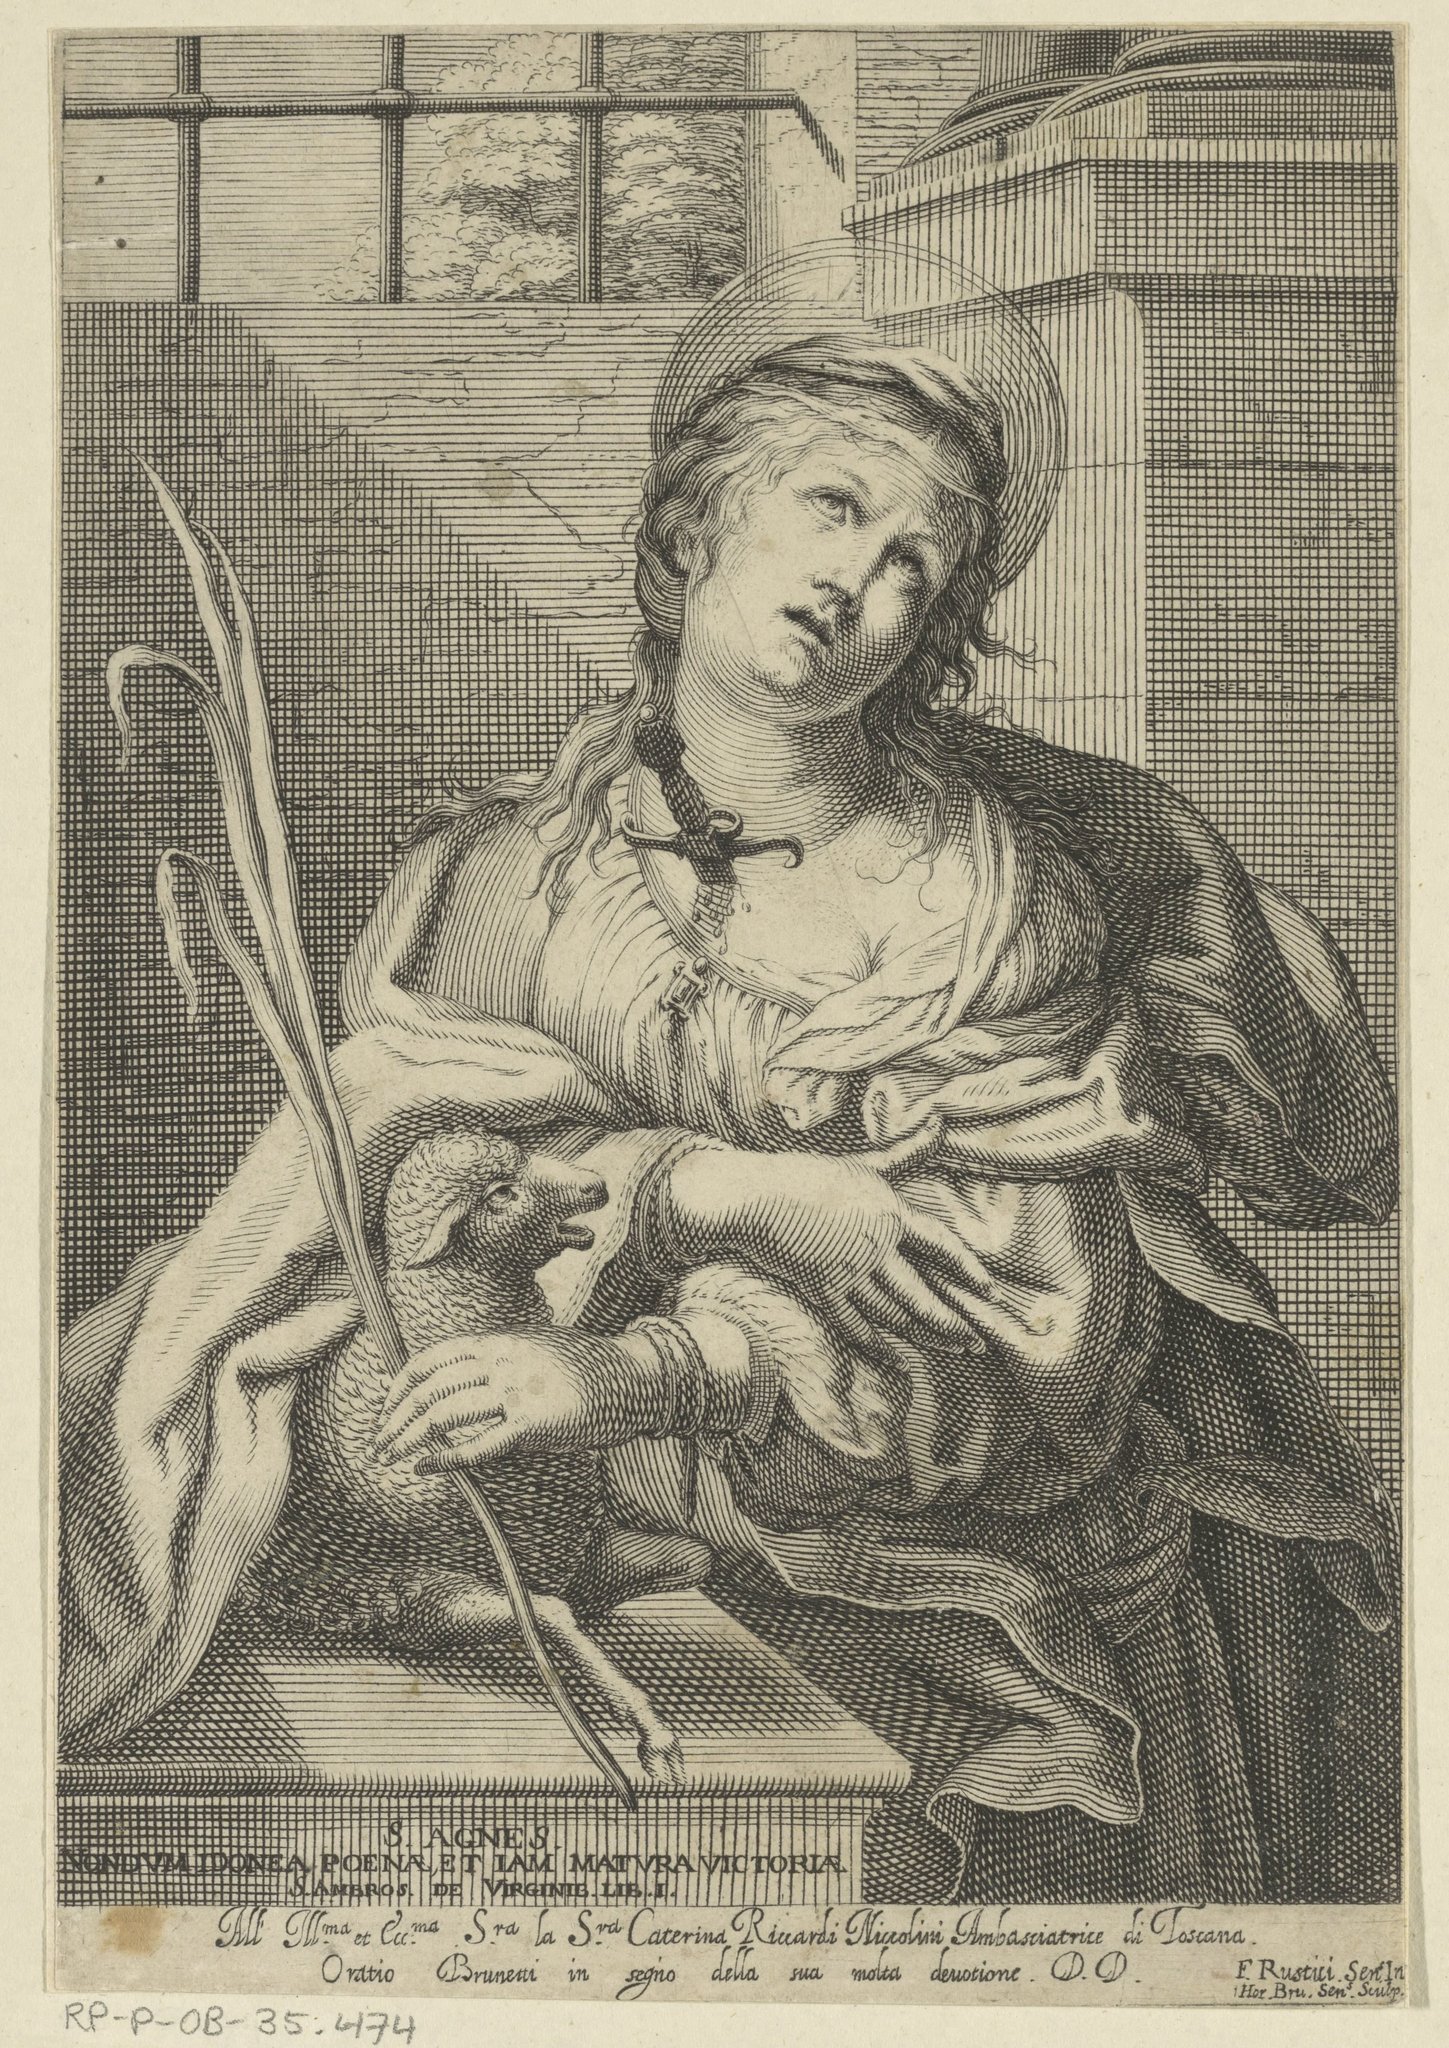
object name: print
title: Heilige Agnes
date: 1640-1740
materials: paper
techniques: engraving, etching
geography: italy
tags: the virgin martyr agnes of rome; possible attributes: lamb, ring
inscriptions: collector's mark: Lugt 240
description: De Heilige Agnes met een plamtak in haar hand, een zwaard in haar borst gestoken en een lam voor zich. Tekst in ondermarge